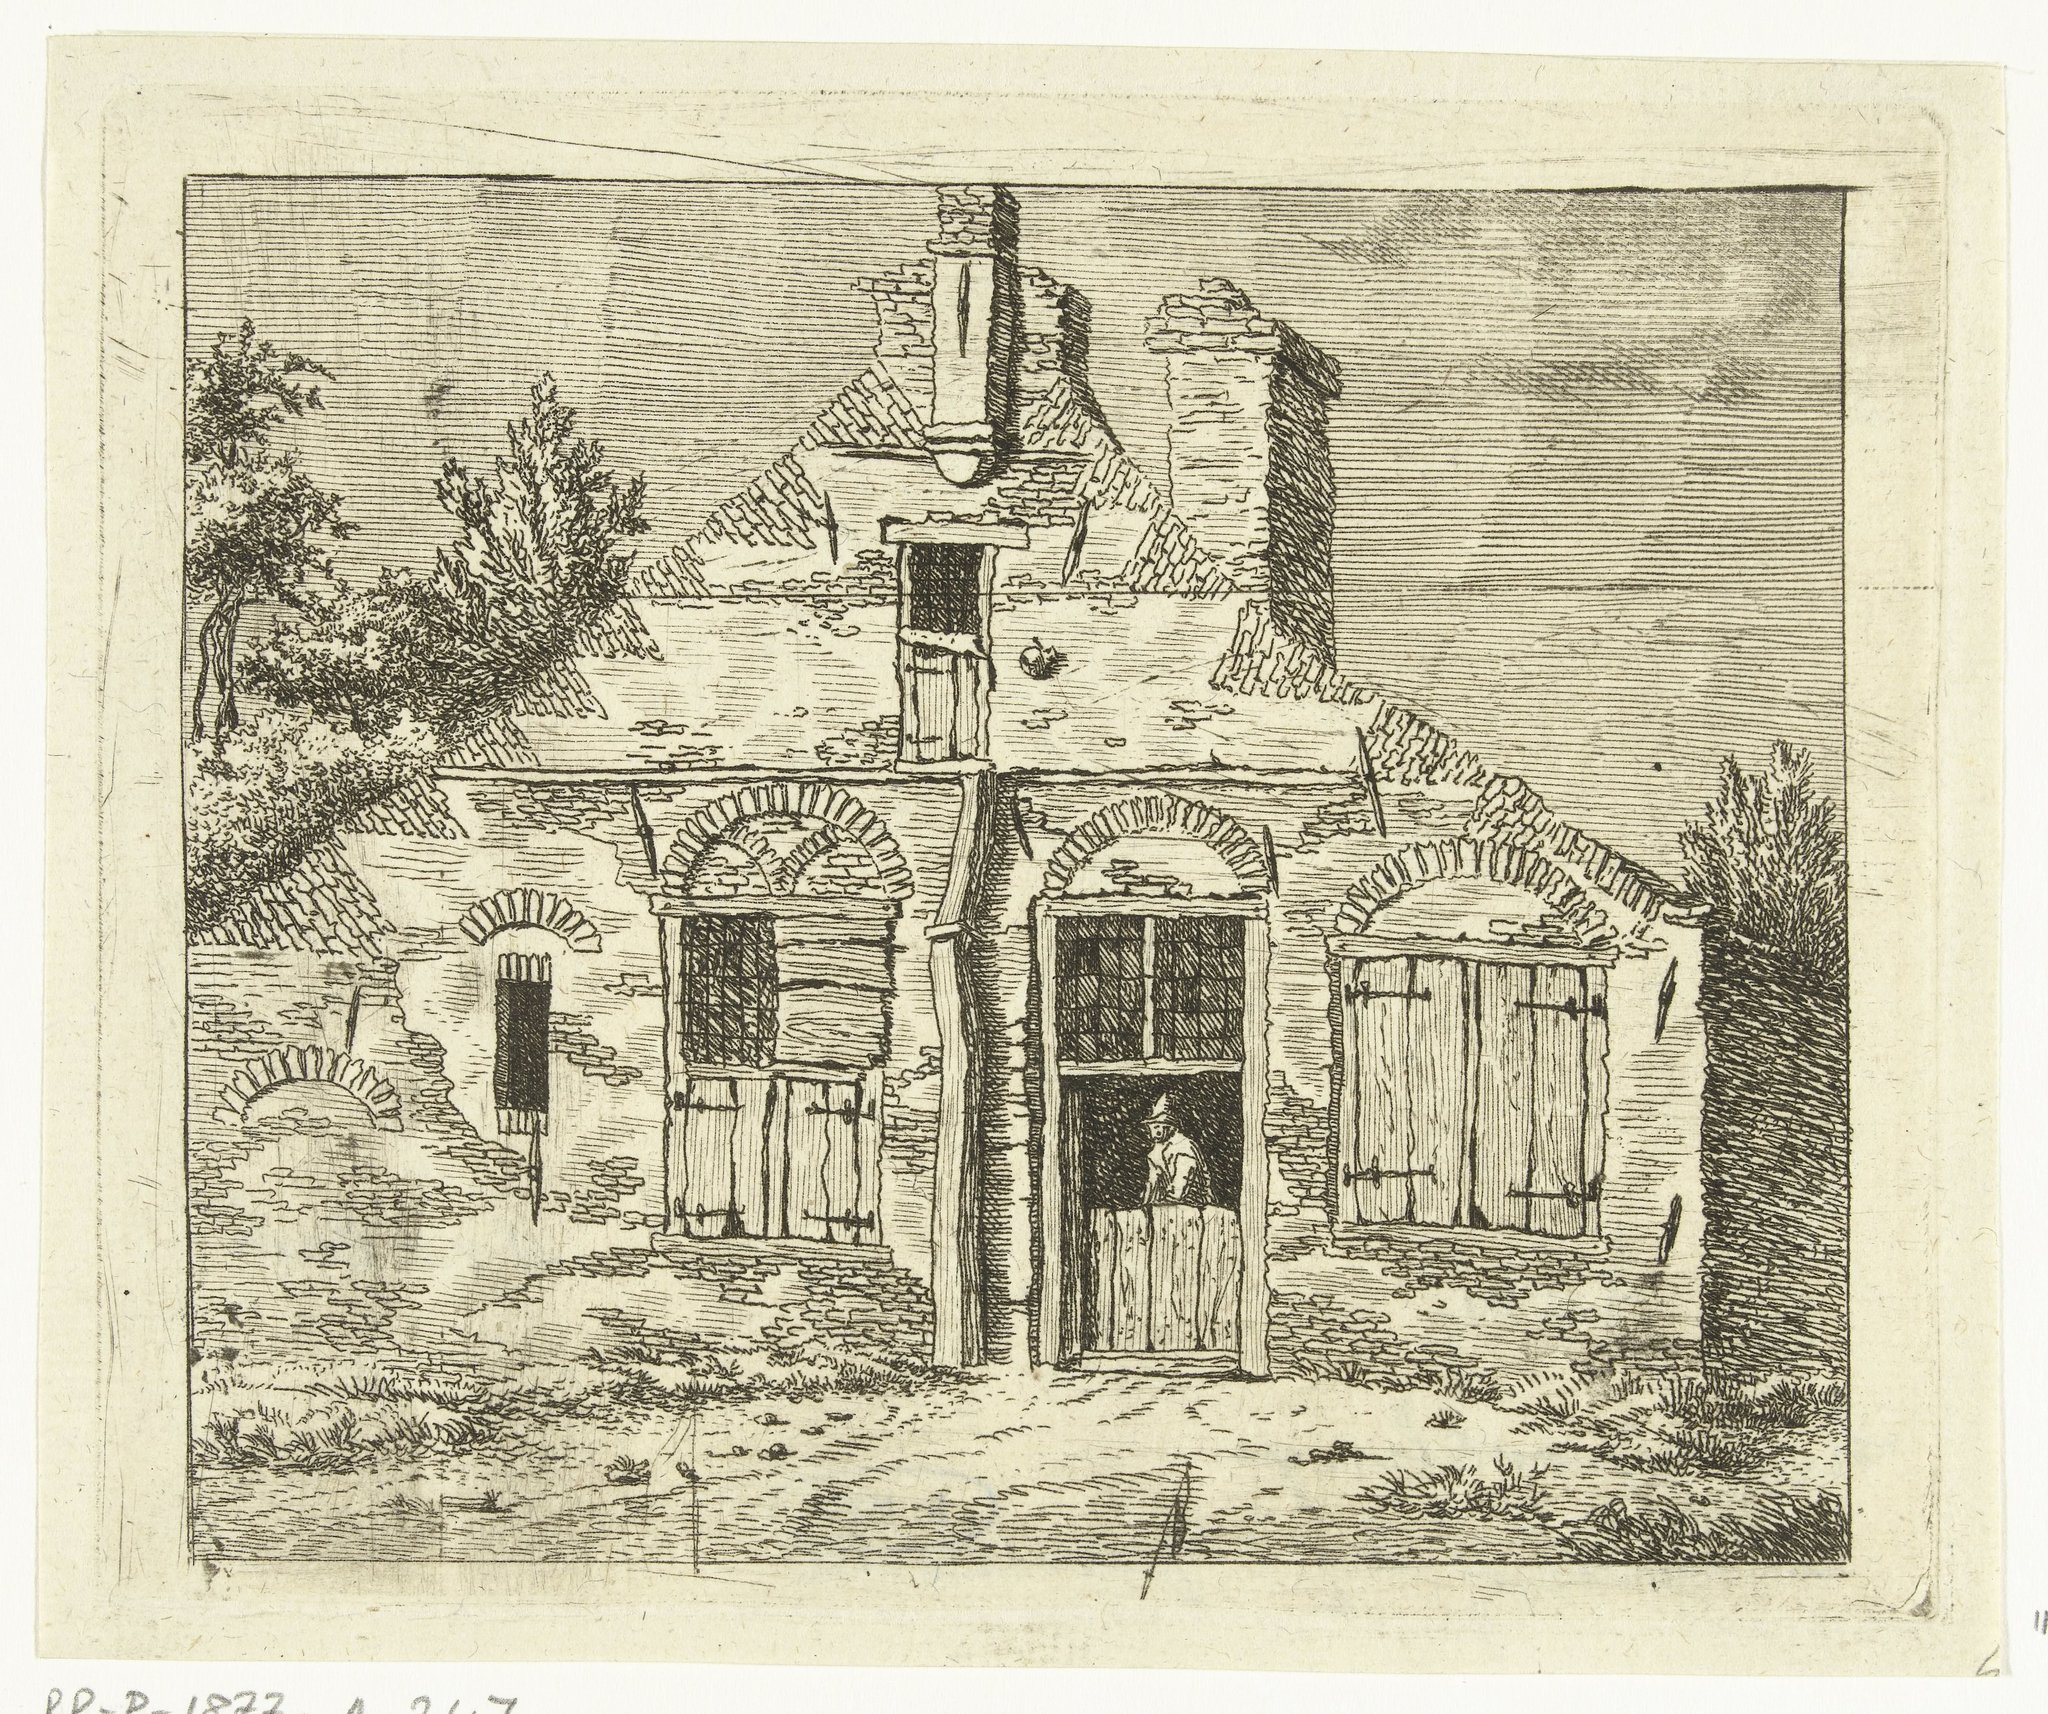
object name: print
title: Man in oud huis, naar buiten kijkend over de deur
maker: anthonie van den bos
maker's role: draughtsman, print maker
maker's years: 1763-1838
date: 1778-1838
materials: paper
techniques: etching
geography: netherlands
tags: farm (building), ruin of a dwelling, house, castle, etc.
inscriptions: collector's mark: Lugt 2228